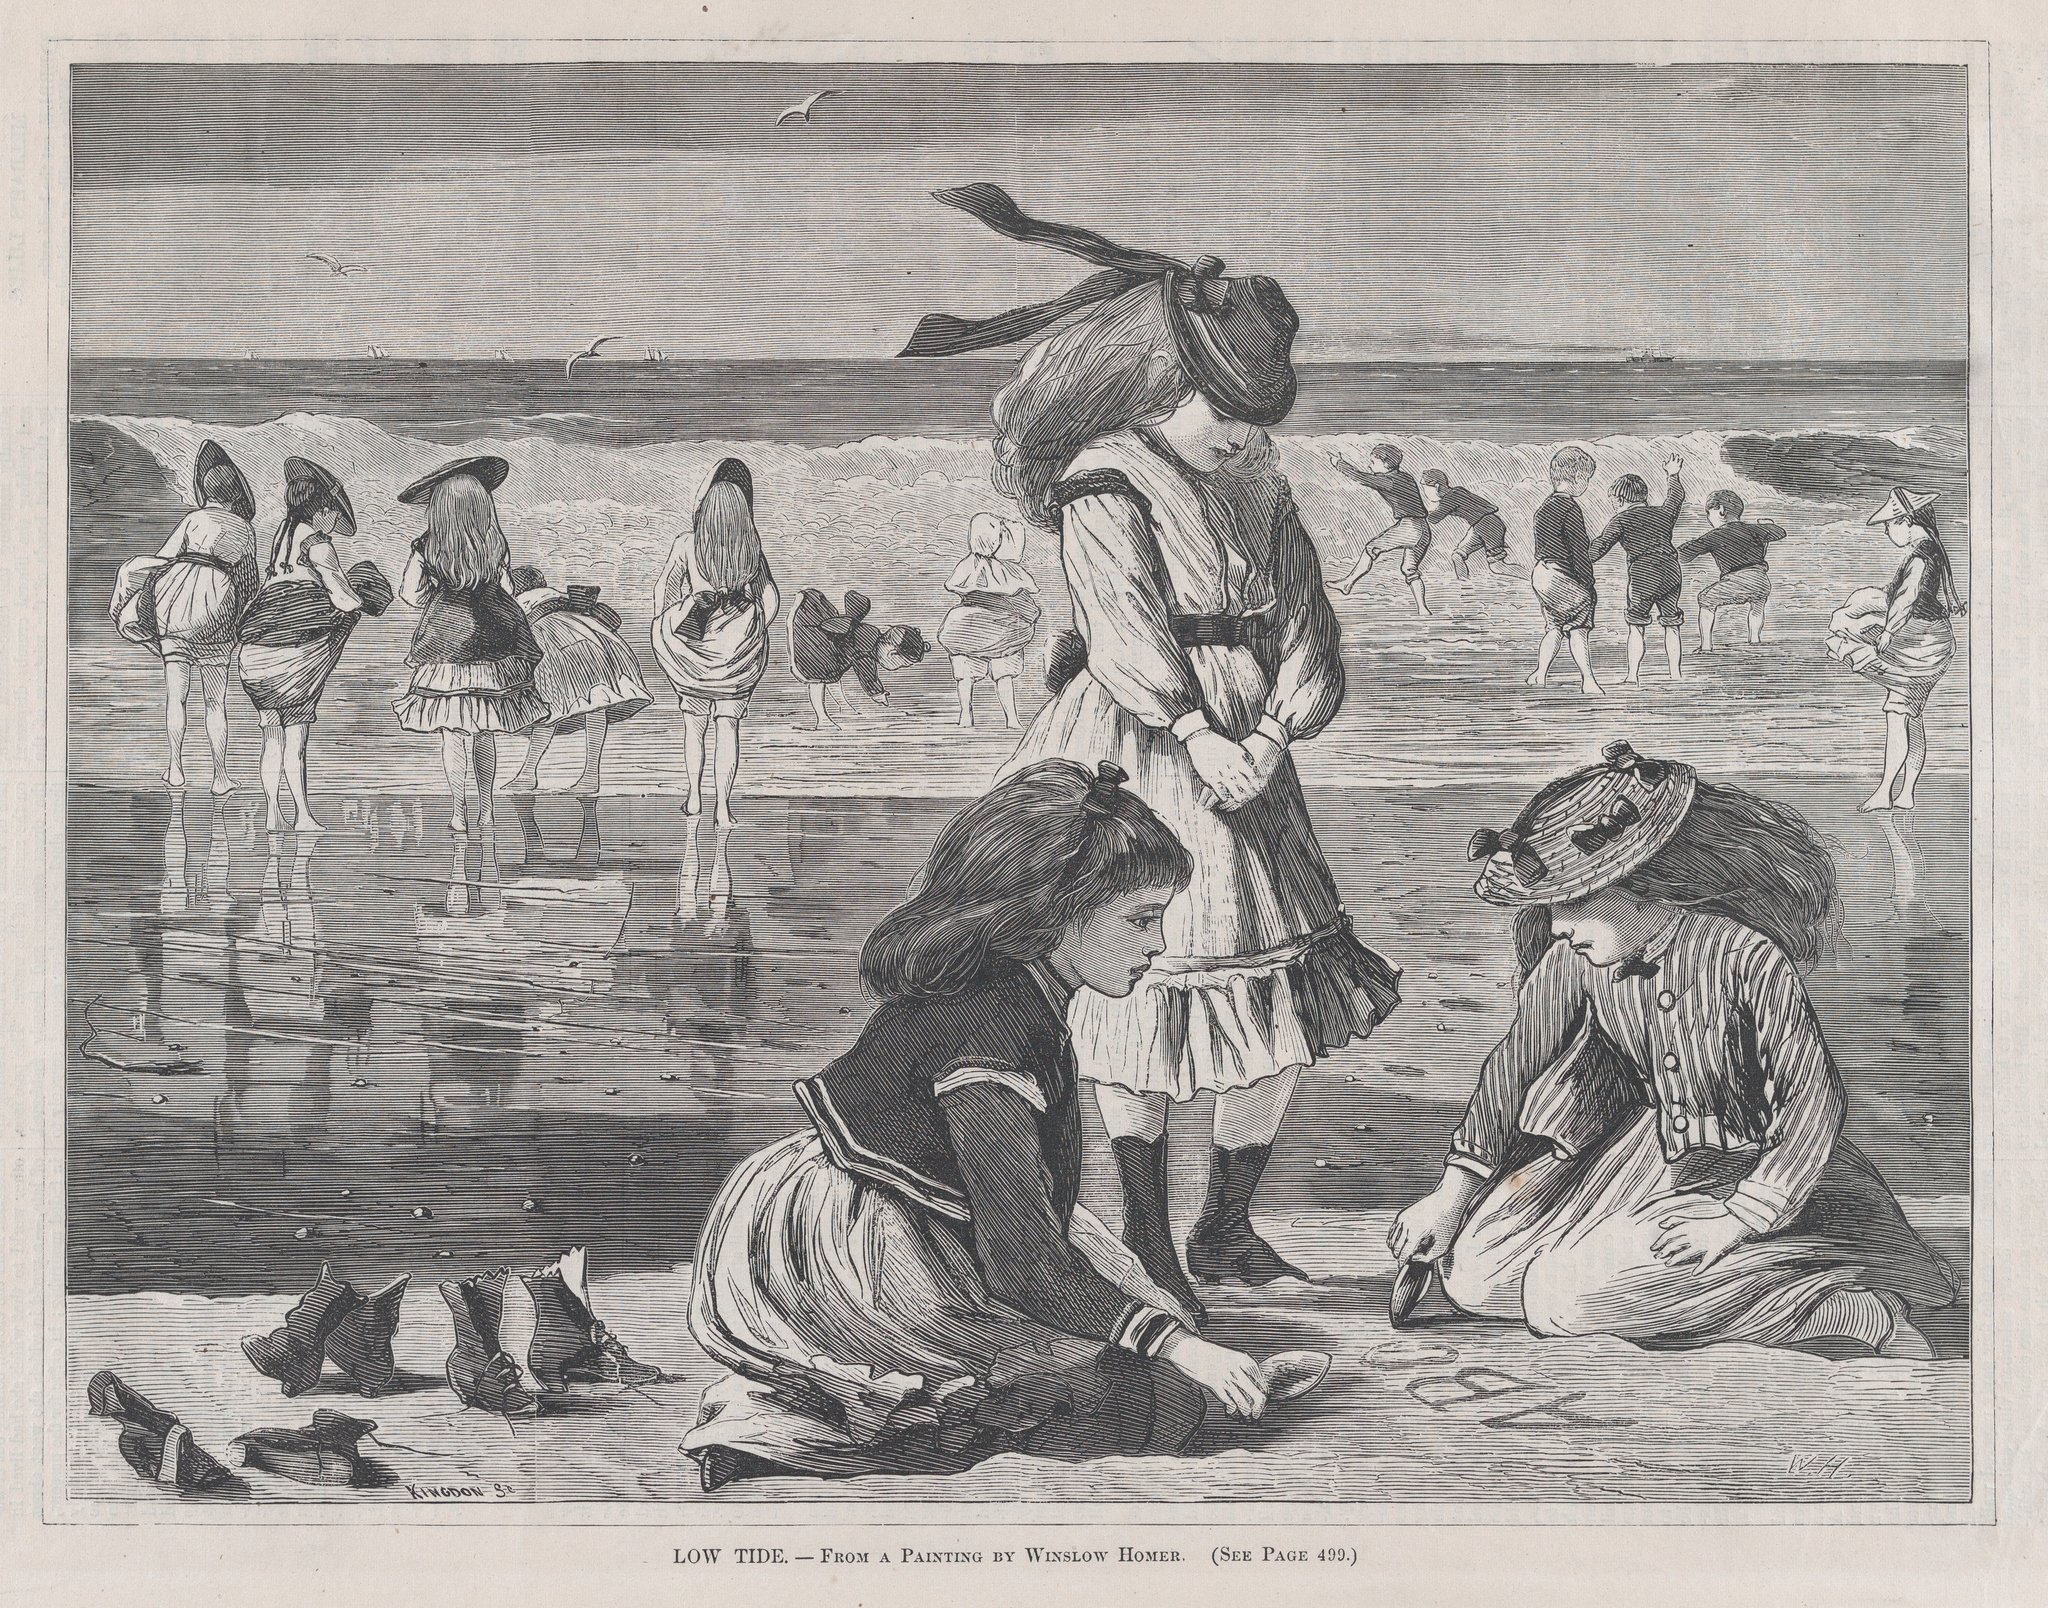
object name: print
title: Low Tide (from "Every Saturday," Vol. I, New Series)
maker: winslow homer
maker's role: artist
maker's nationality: american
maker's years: 1836-1910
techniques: engraving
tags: footwear,boys,girls,women,beaches